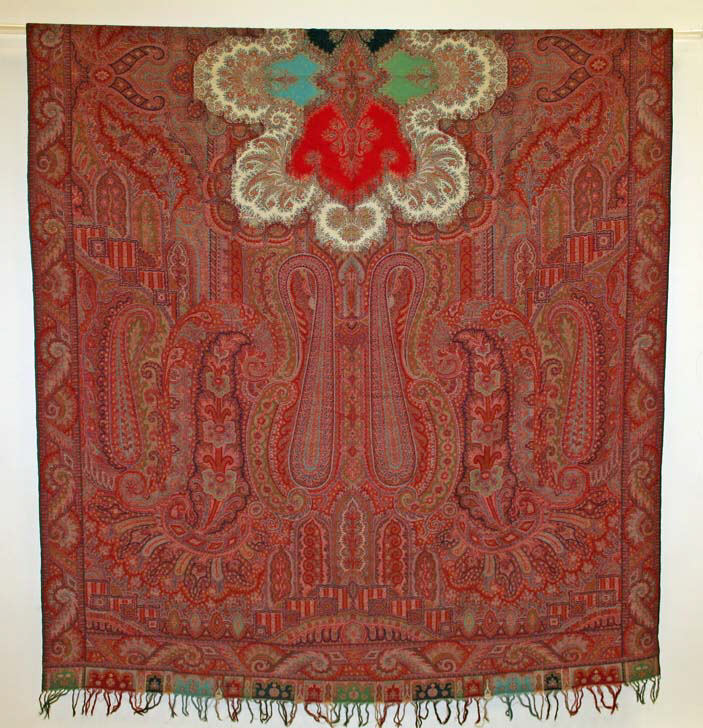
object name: shawl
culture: european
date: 1850-1855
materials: silk, wool